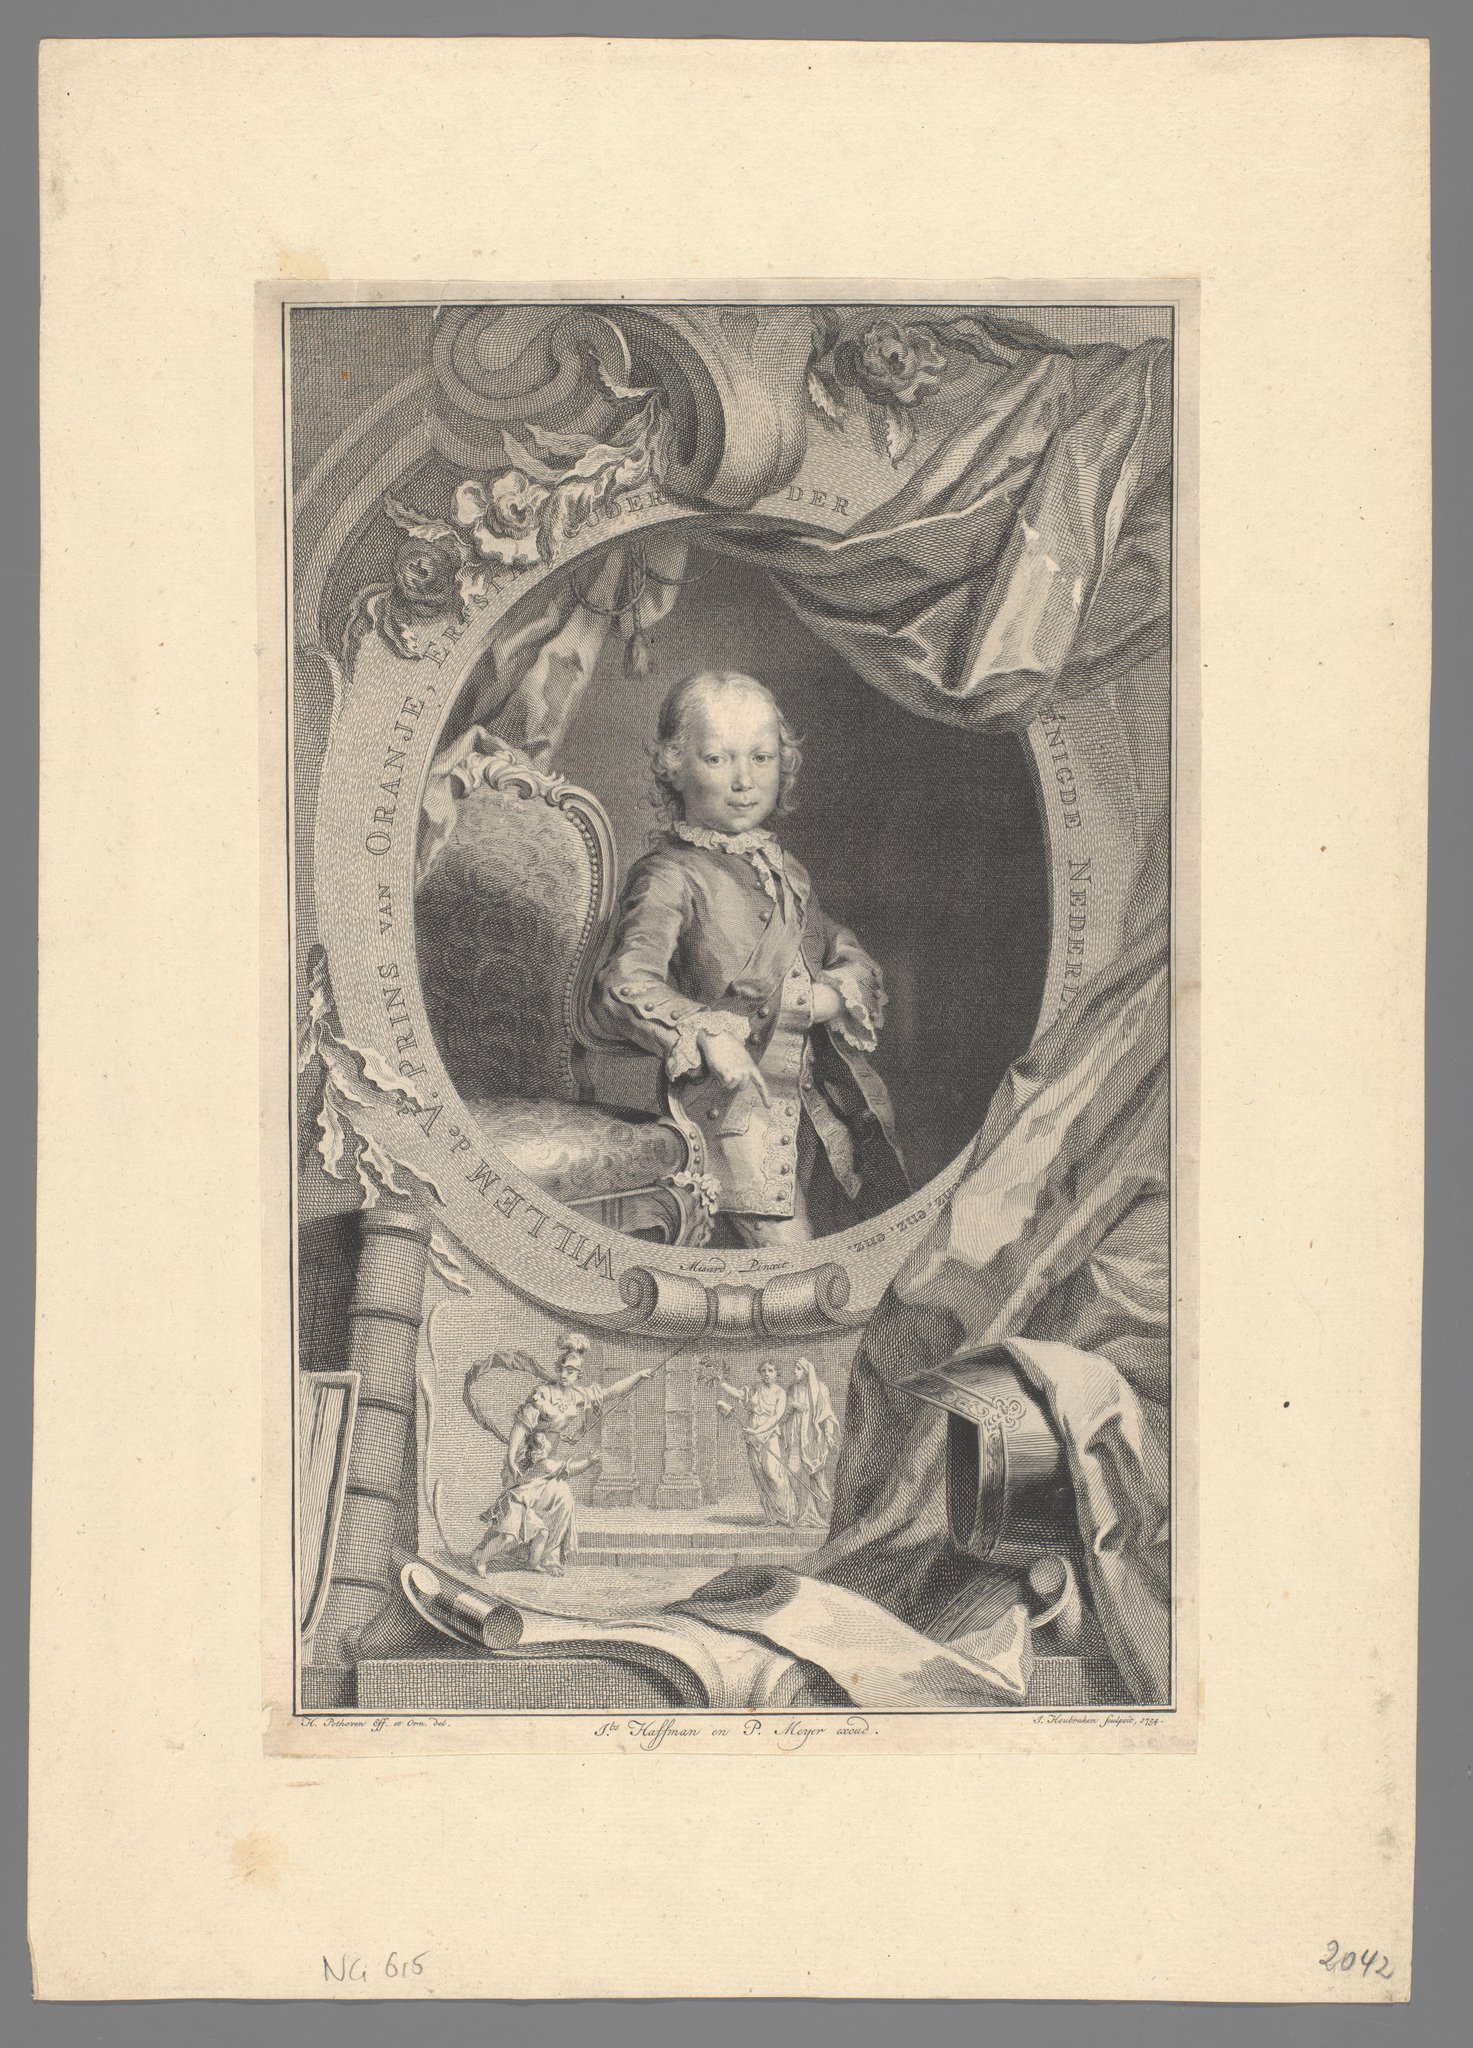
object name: print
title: Portret van Willem V, prins van Oranje-Nassau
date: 1754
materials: paper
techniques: engraving, etching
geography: amsterdam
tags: the hague, william v (prince of orange)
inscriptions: date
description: Portret van Willem V in een ovaal met randschrift. Rondom ligt een aantal allegorische objecten, waaronder een helm en een boek. Op het reliëf een allegorische voorstelling.